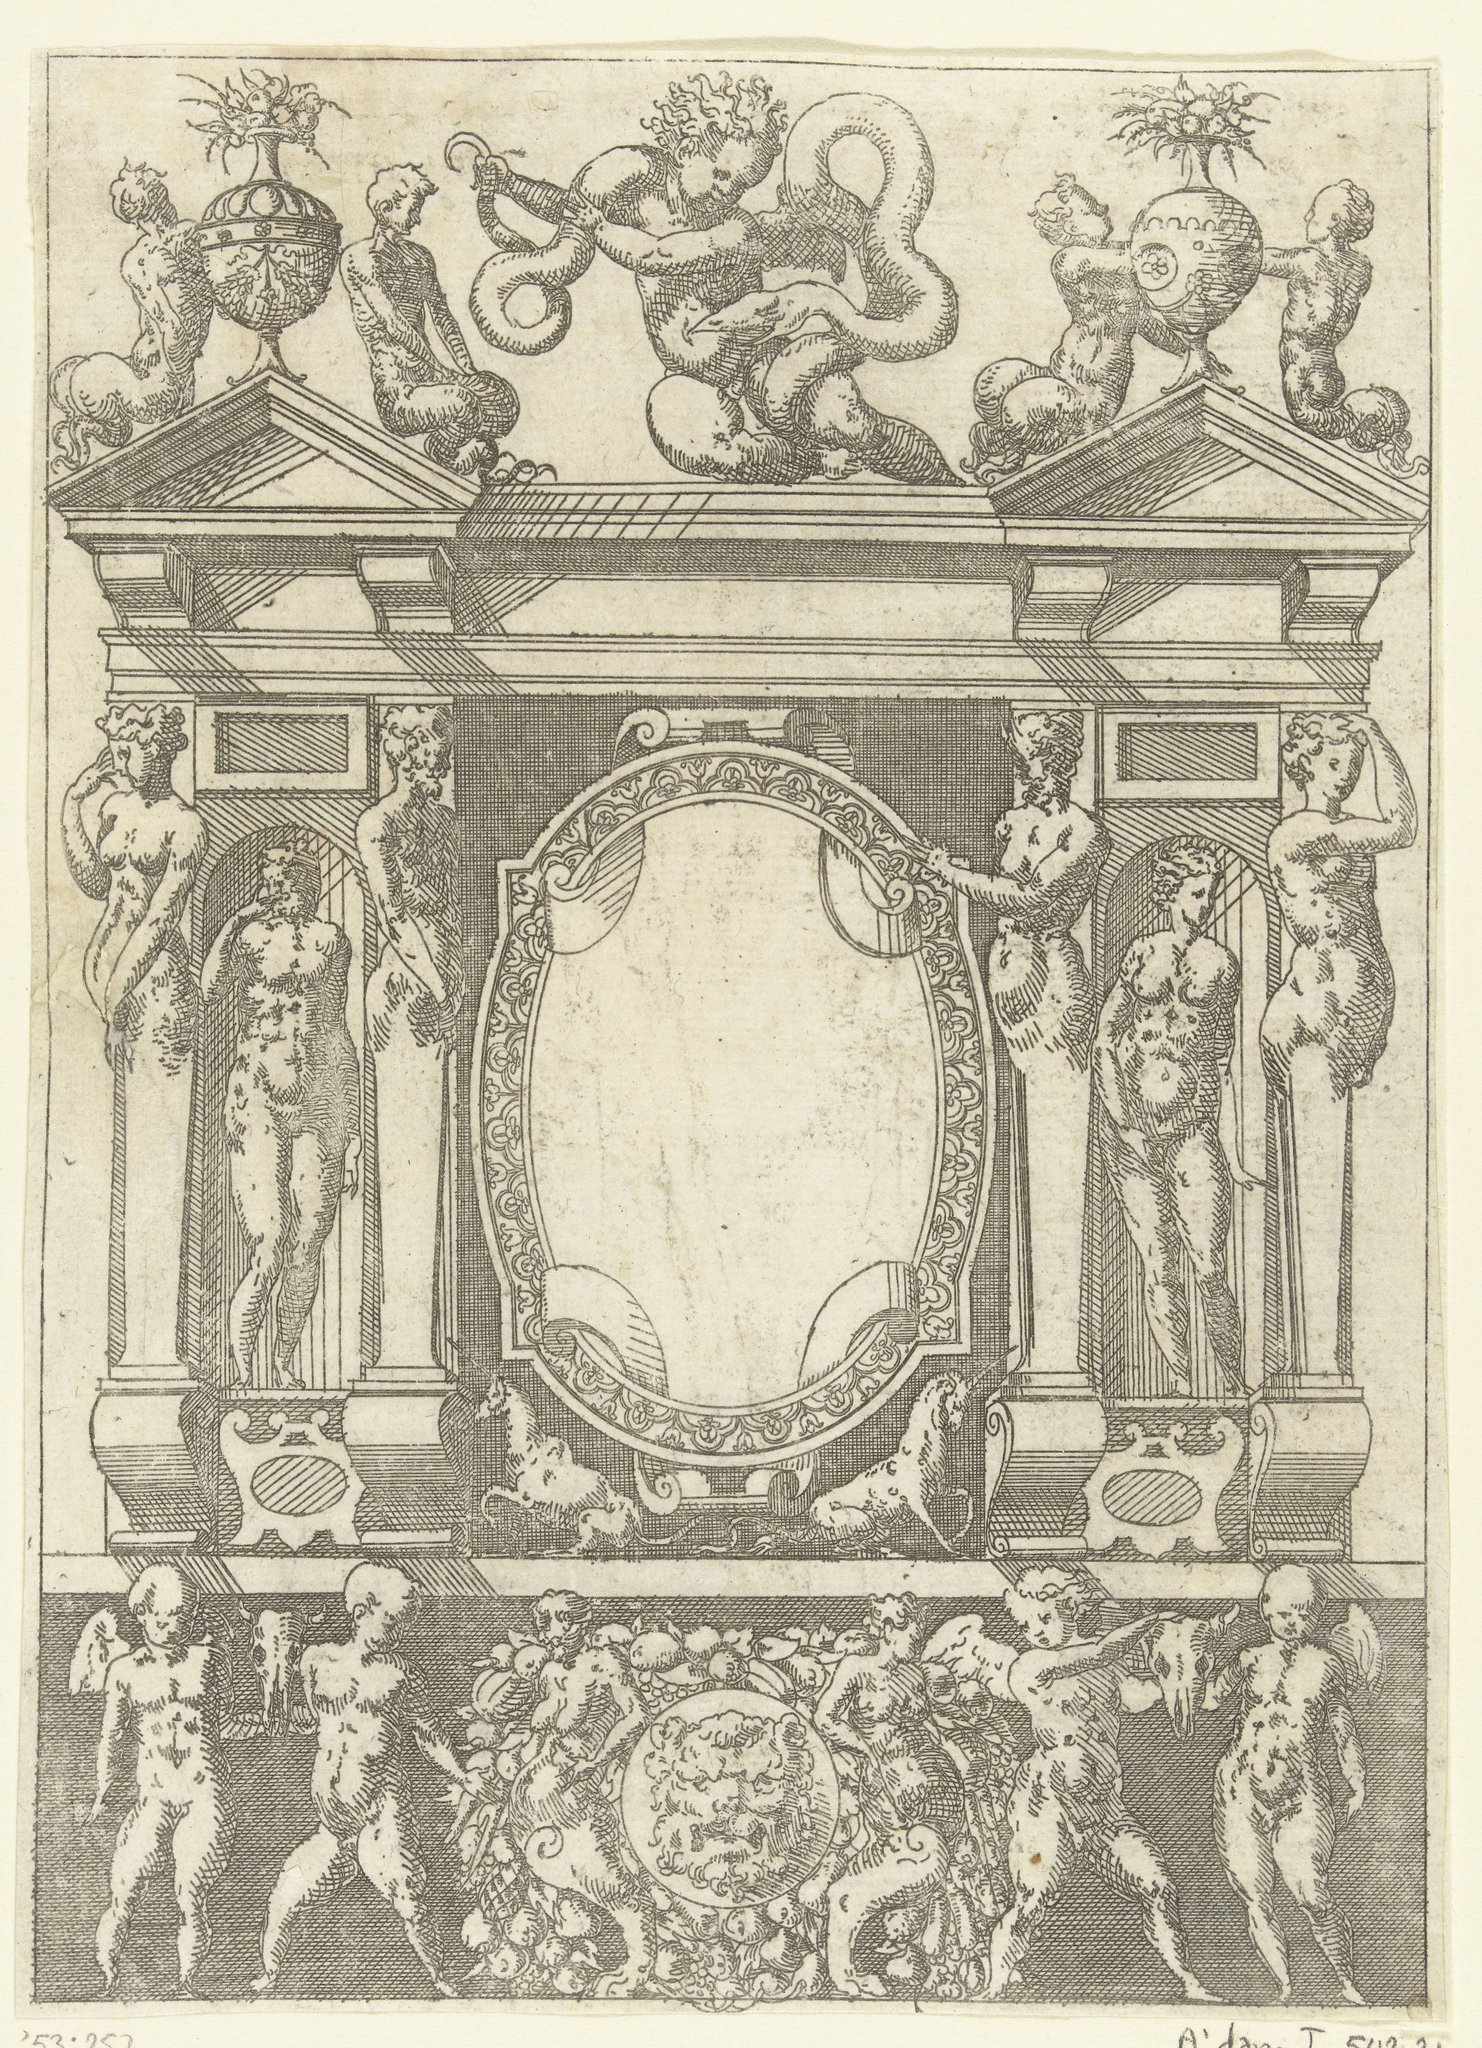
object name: ornament print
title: Ovale cartouche in een tempelfront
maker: Anonymous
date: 1520-1584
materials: paper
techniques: etching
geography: france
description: Midden boven zit een putto, vechtend met een slang. Uit serie van 32 bladen. De cartouches zijn deels ontleend aan de prenten van Antonio Fantuzzi naar de decoratie van de Galerie van François 1er door Giovanni Battista Rosso. De serie staat ook bekend onder de titel Petits cartouches de Fontainebleau.